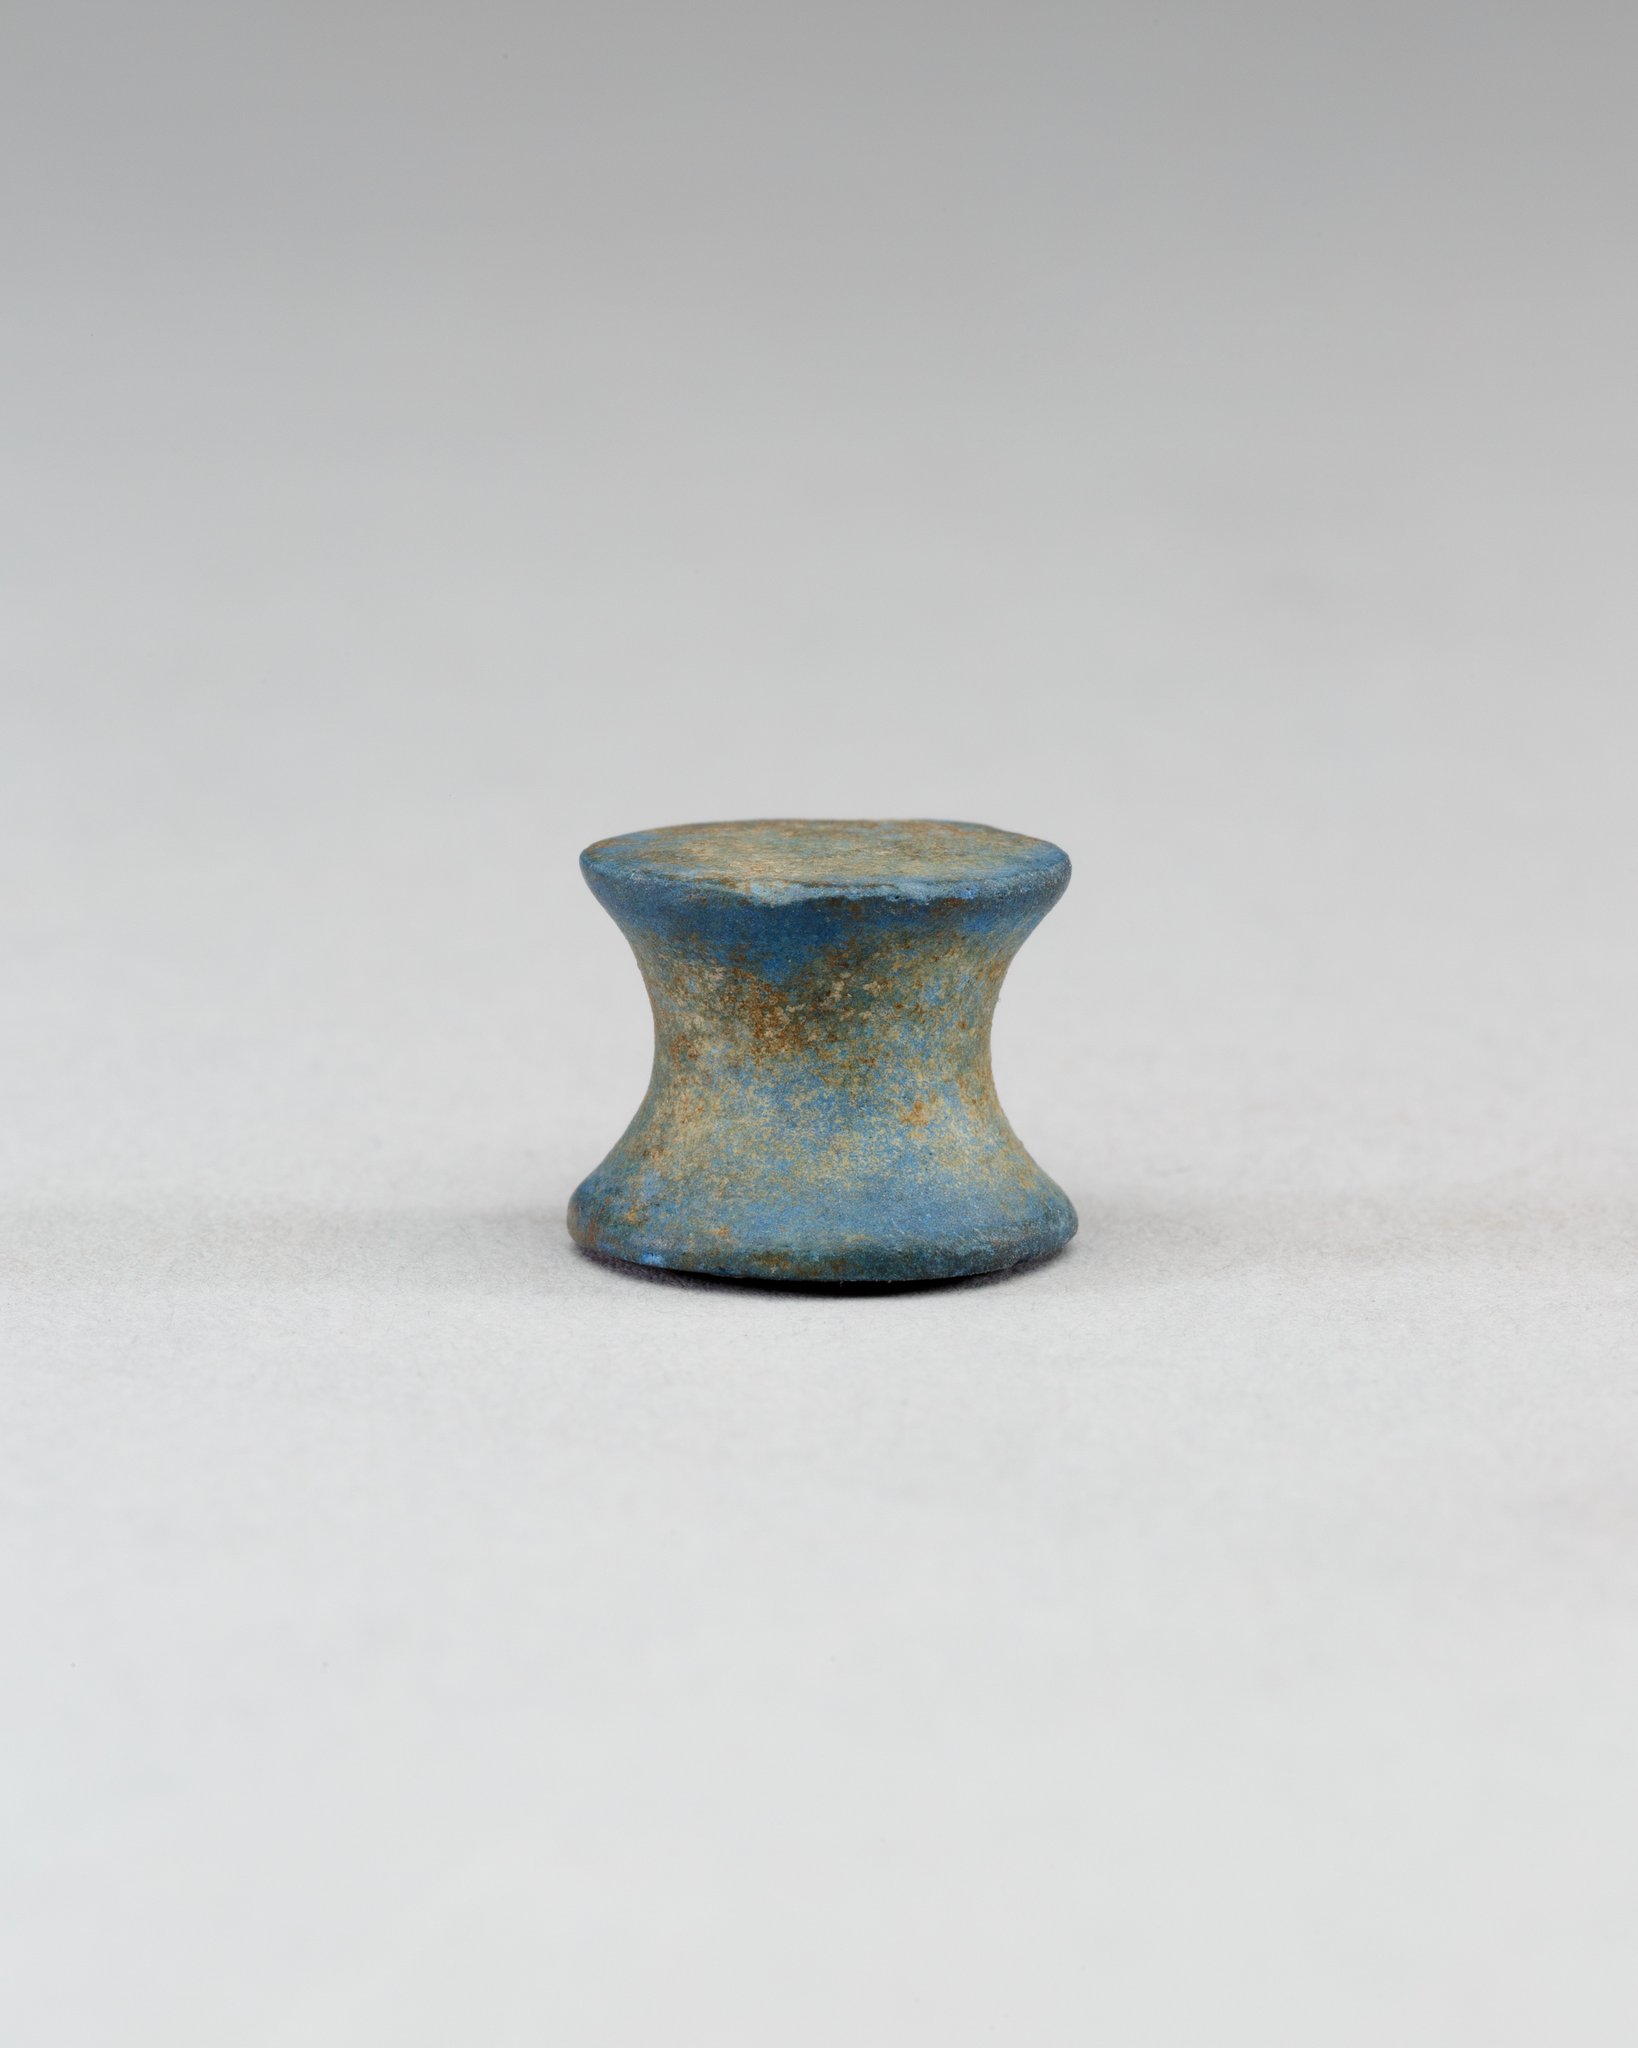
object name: game piece, spool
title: Spool-Shaped Game Piece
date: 1504-1447 BCE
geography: egypt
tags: games